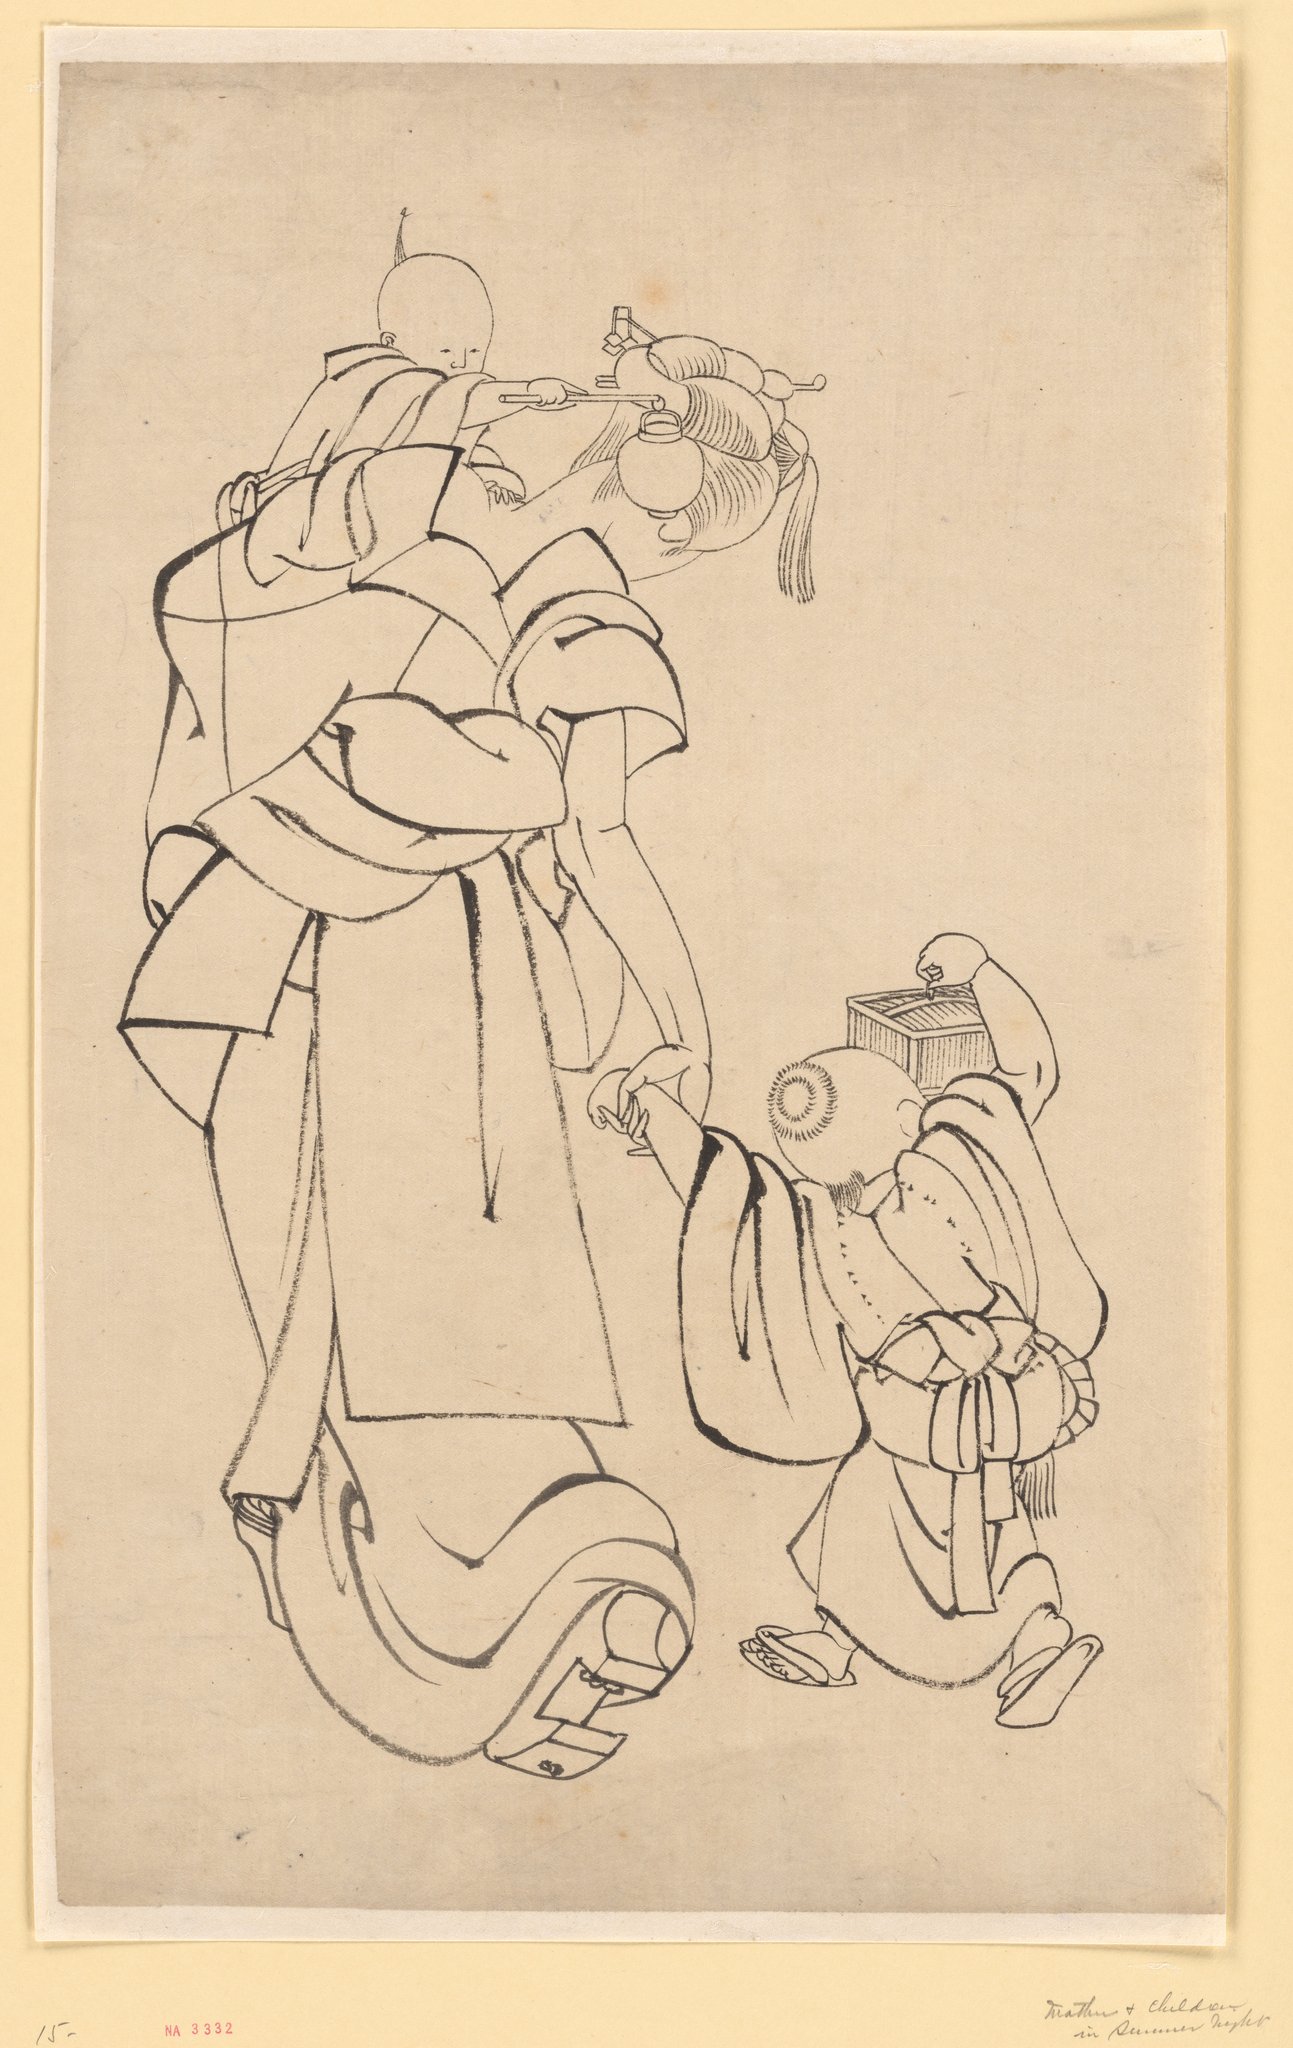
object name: drawing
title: Mother and Children in Summer Night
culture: japanese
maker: katsushika hokusai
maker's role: artist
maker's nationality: japanese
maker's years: 1760-1849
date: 1701-1900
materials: ink, paper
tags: children,infants,mothers,women